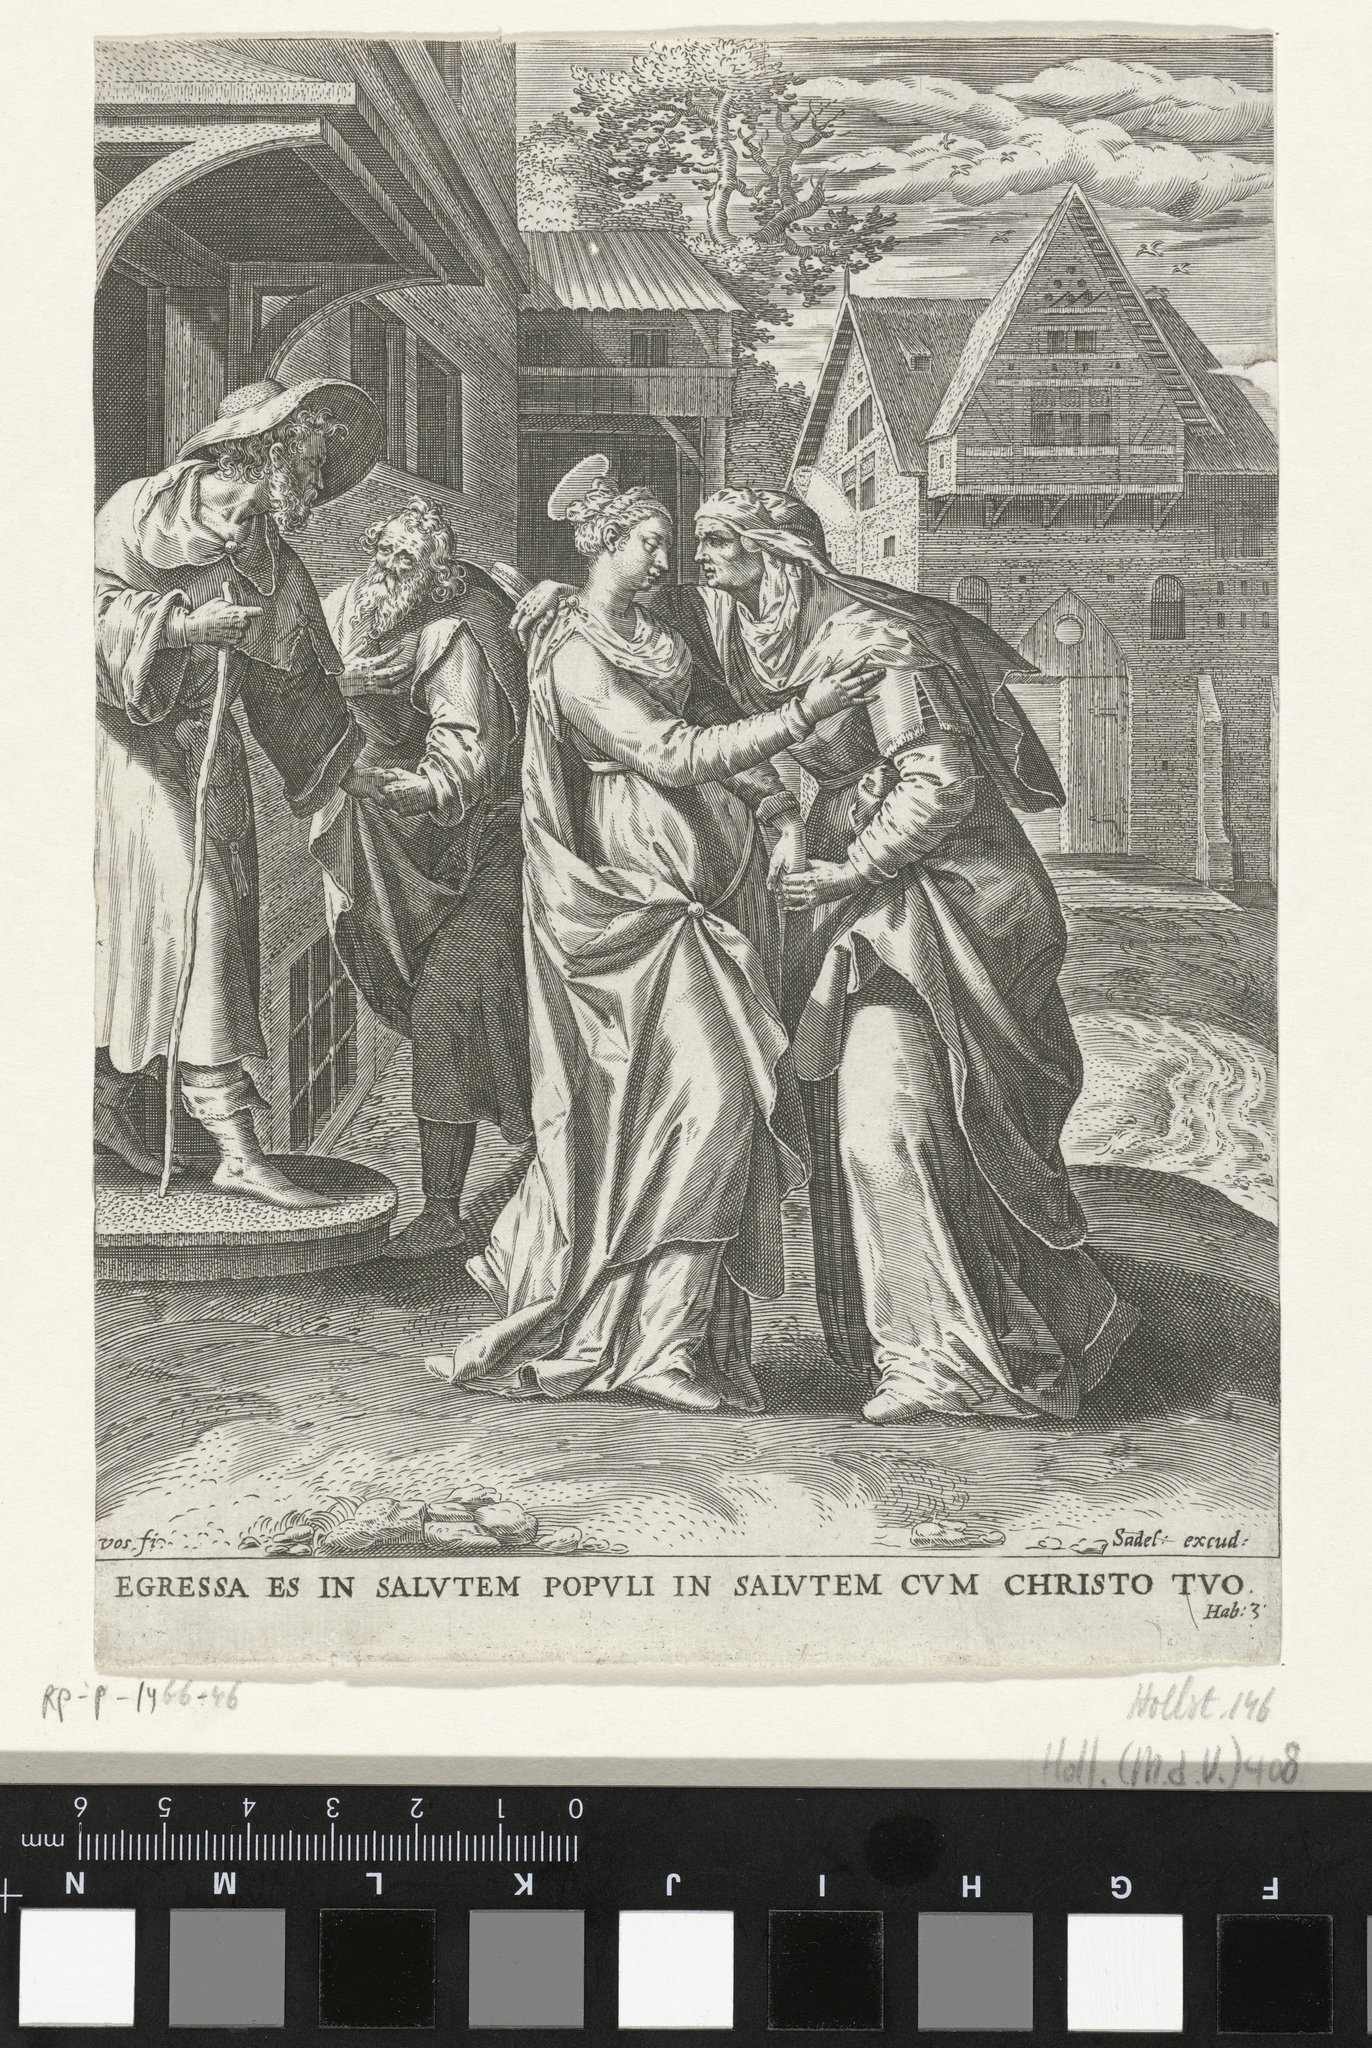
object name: print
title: Visitatie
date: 1587-1589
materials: paper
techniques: engraving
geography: frankfurt am main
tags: mary and elisabeth, both pregnant, embracing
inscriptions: collector's mark: Lugt 2228, collector's mark: Lugt 2760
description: Bezoek van Maria aan haar nicht Elisabet. De twee omhelzen elkaar. Links schudden Jozef en Zacharias elkaar de hand. De prent heeft een Latijns Bijbelcitaat als onderschrift en is de tweede prent van een vijftiendelige serie over het leven van Christus en de maagd Maria.